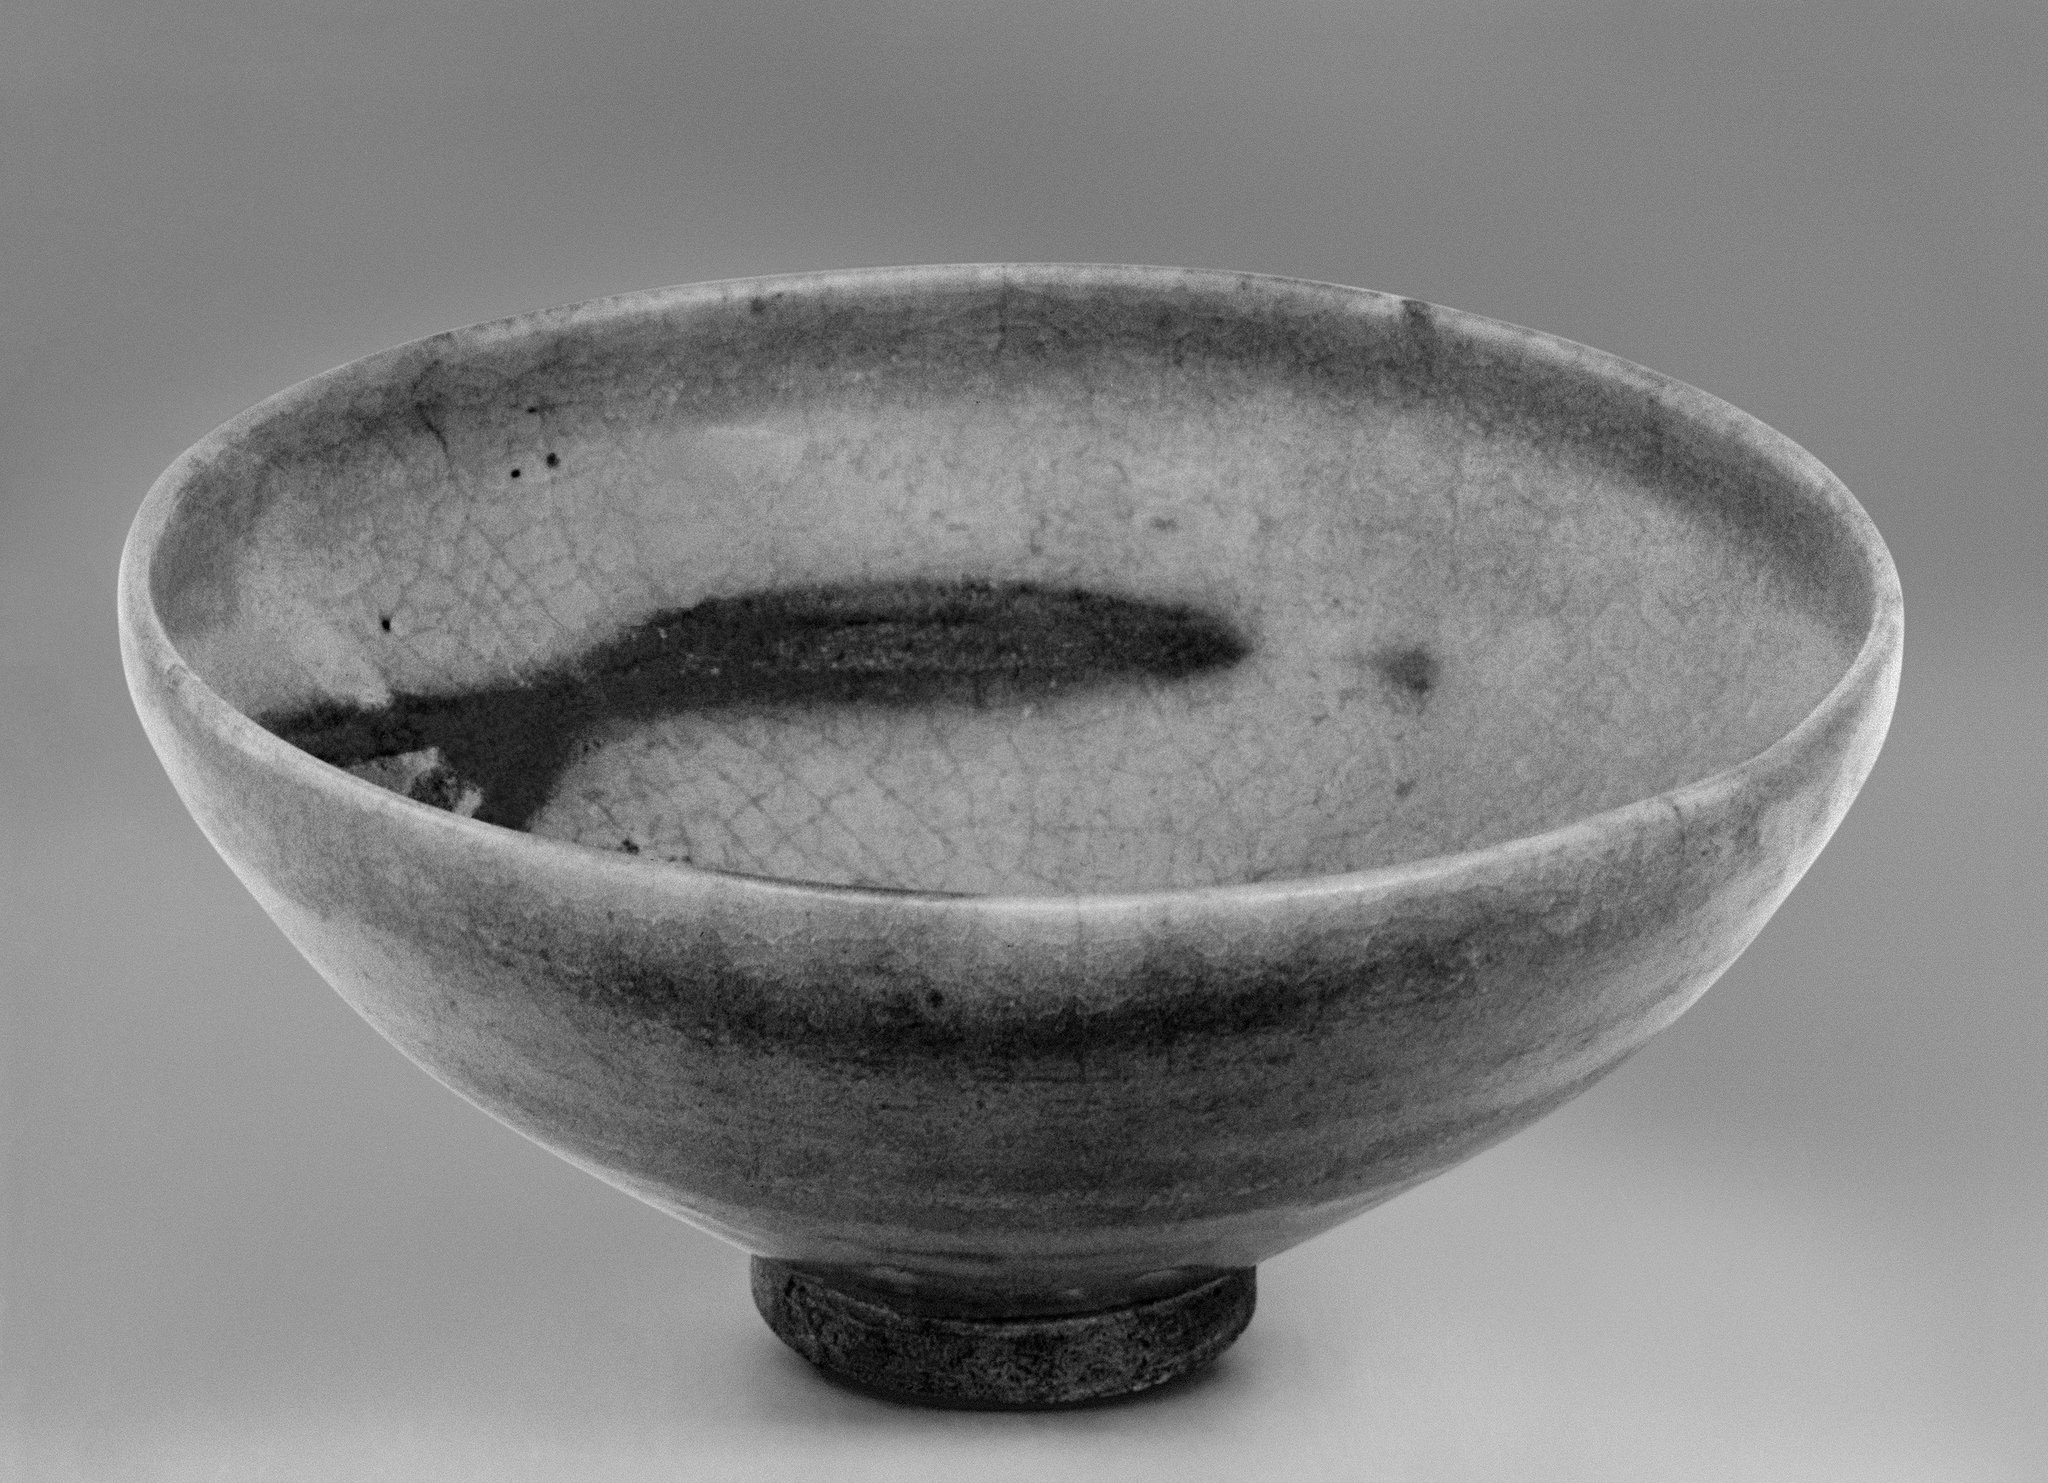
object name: bowl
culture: chinese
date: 1167-1300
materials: glaze, stoneware